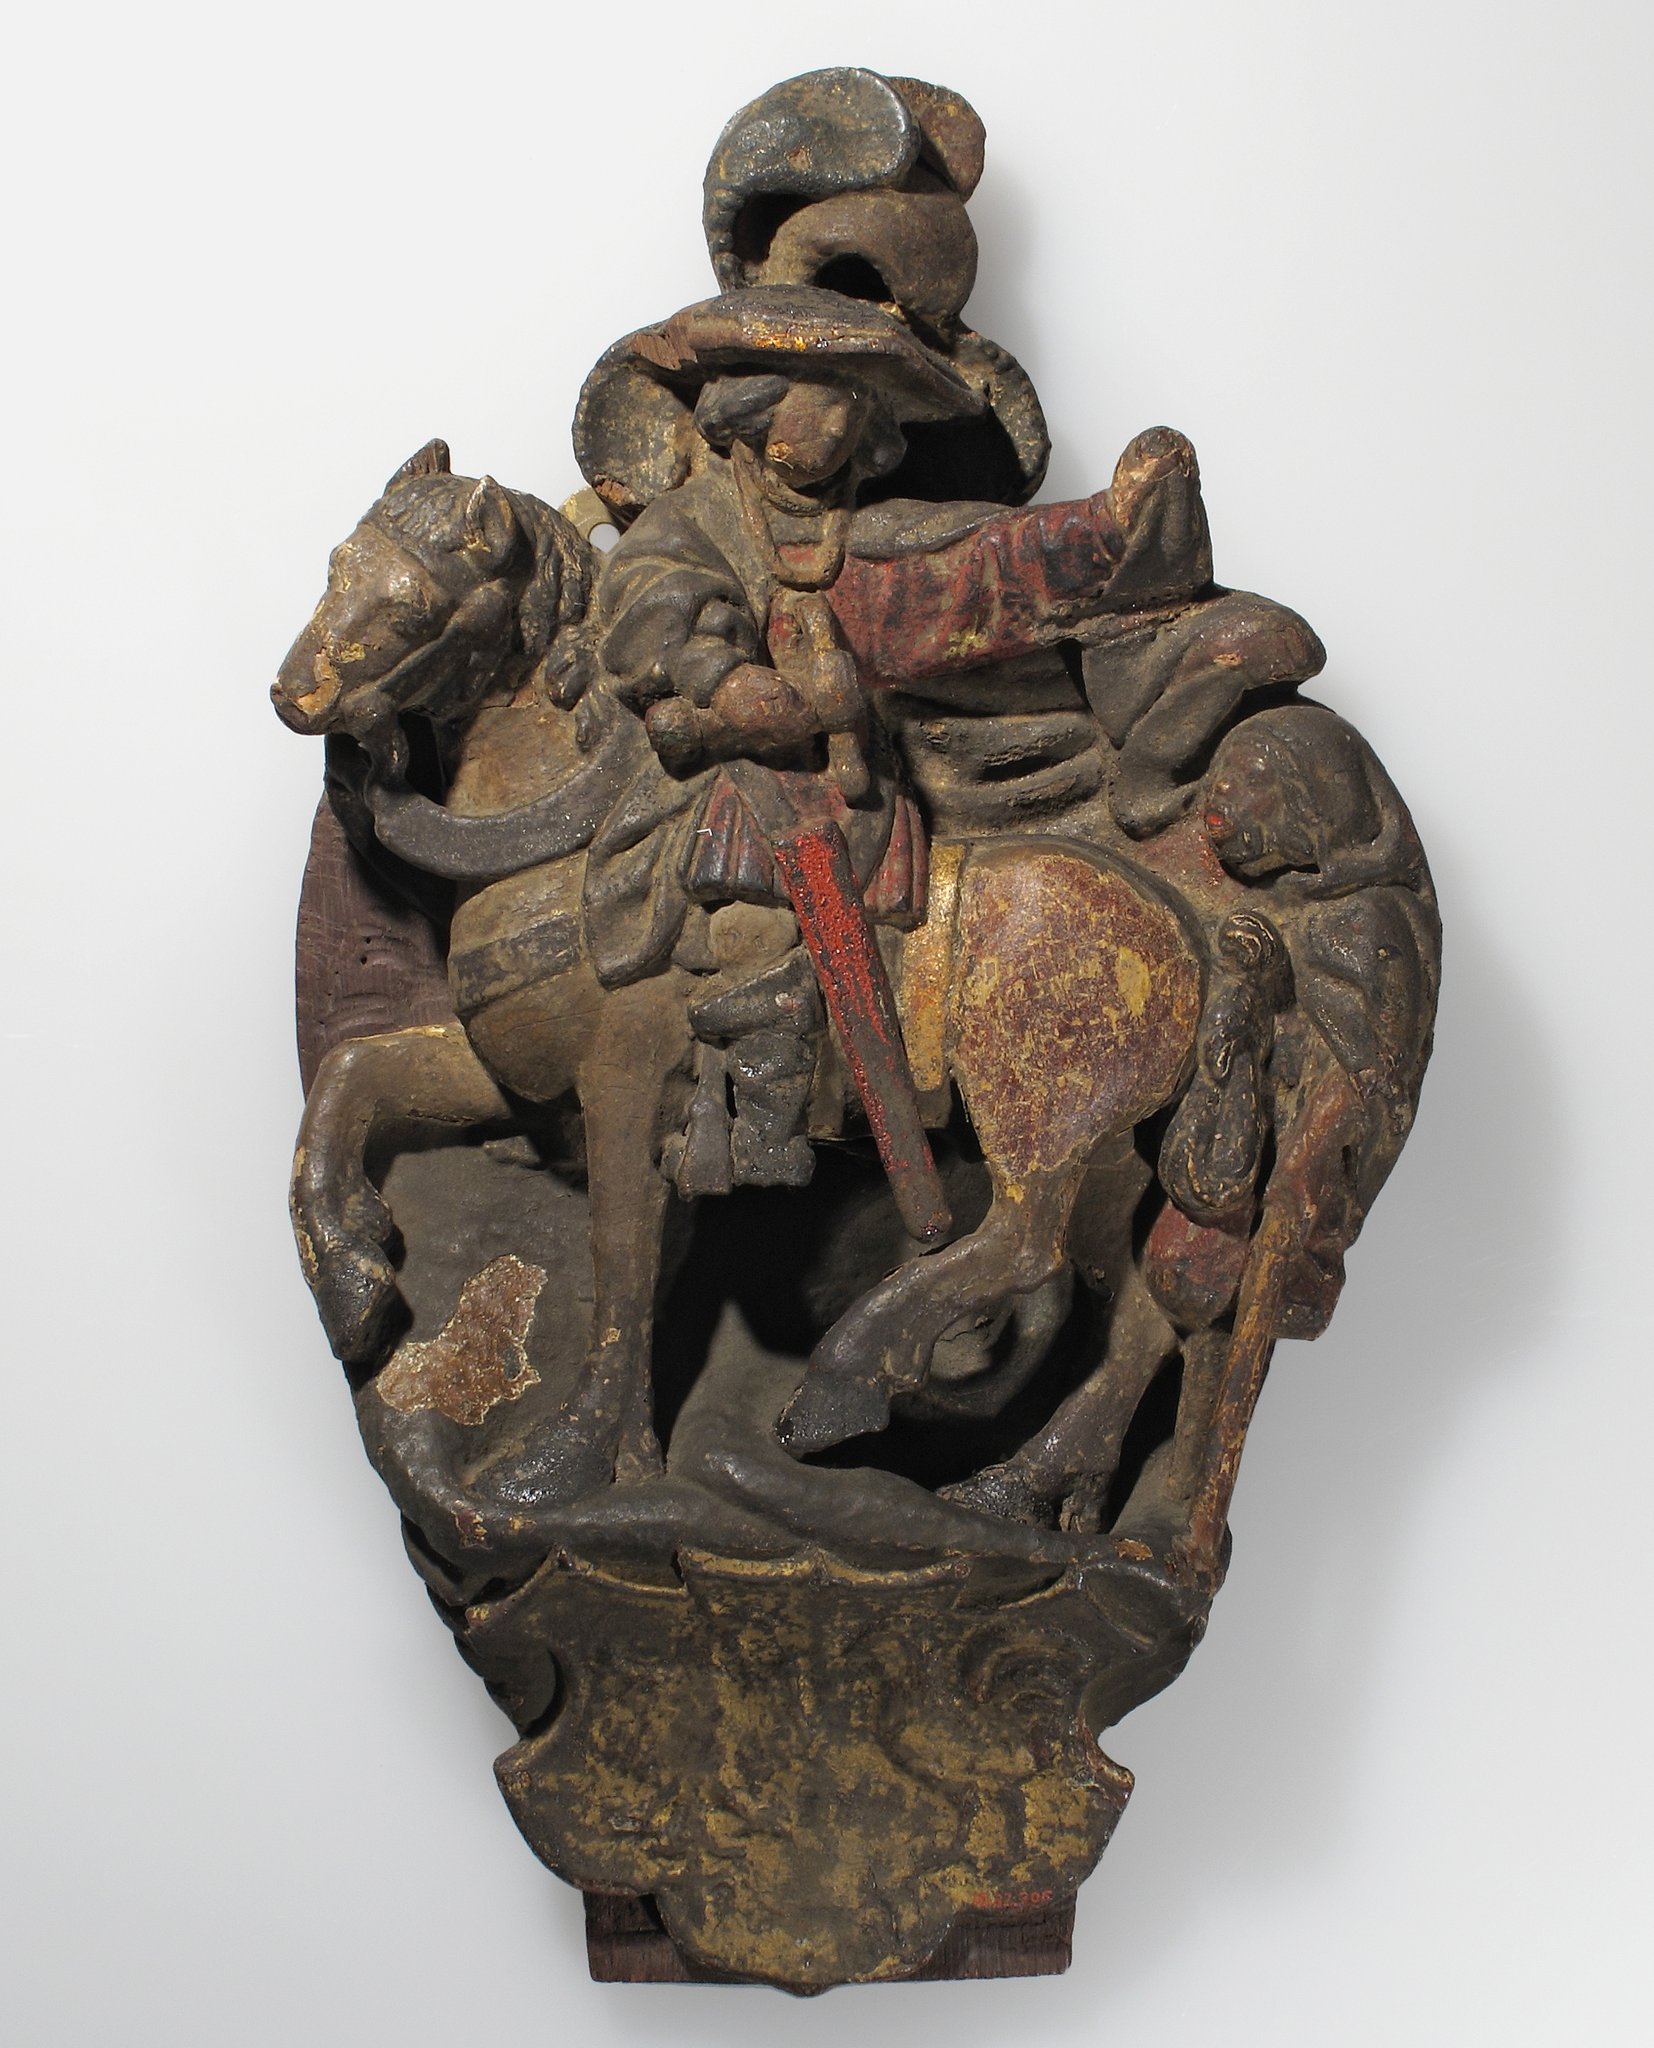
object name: bellow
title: Bellows with Relief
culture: french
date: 1501-1533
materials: wood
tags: men,horses